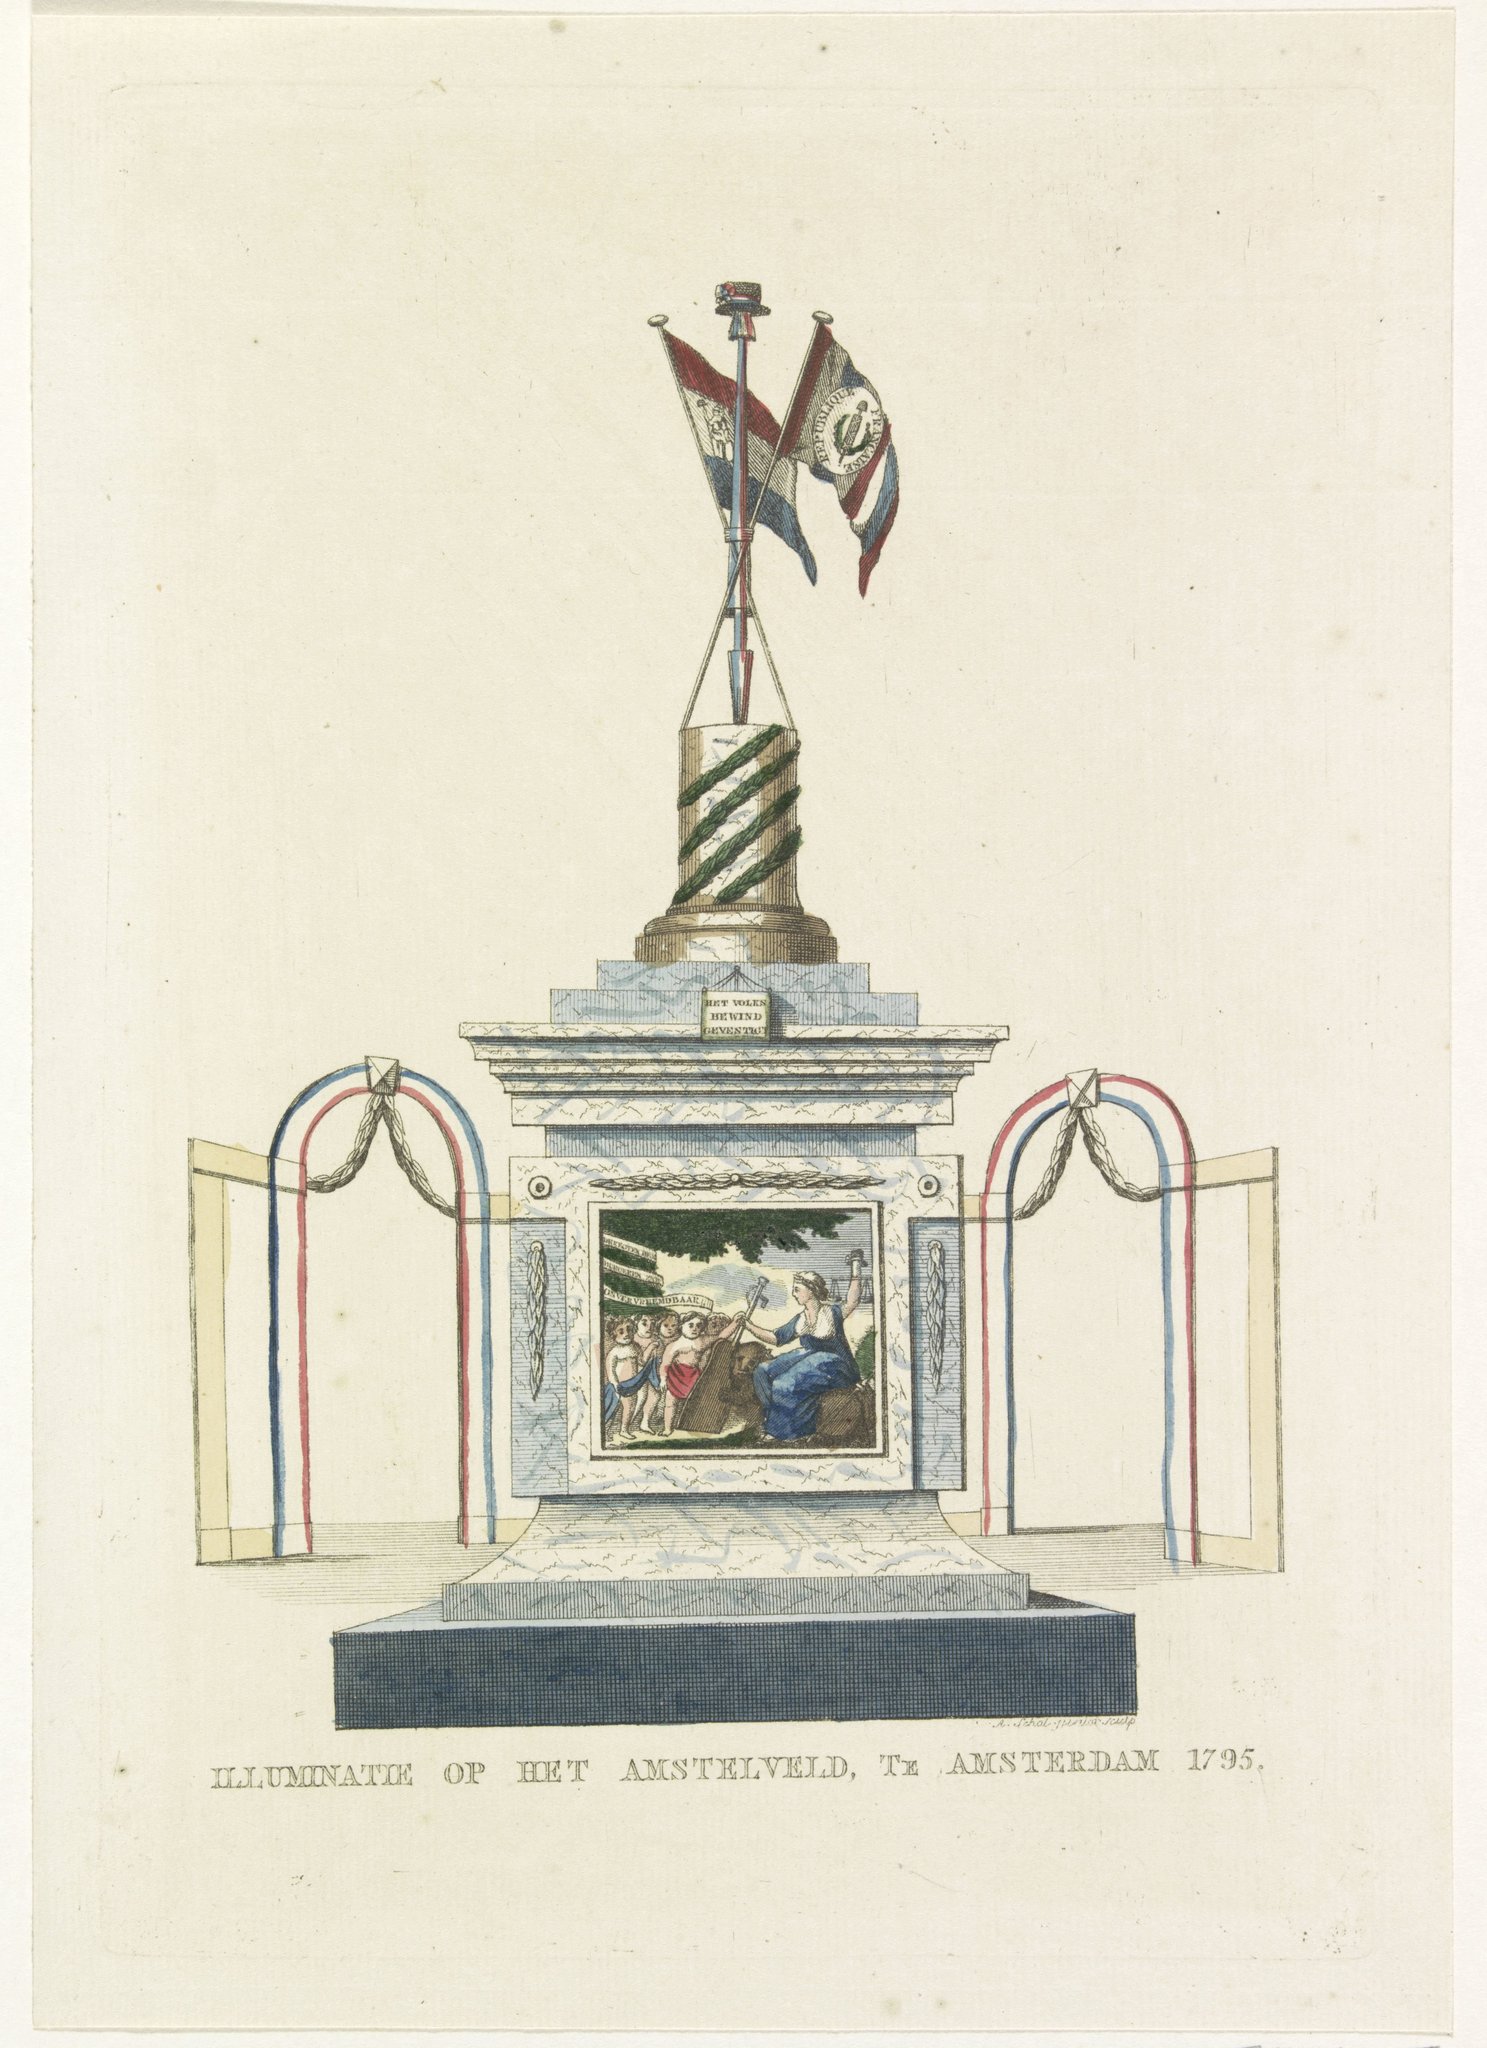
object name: print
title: Dertien decoraties bij het Alliantiefeest te Amsterdam in 1795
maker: a. schol (ii)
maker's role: print maker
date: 1795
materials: paper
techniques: etching, hand coloring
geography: netherlands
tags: personifications of countries, nations, states, districts, etc., festivities on events of national importance (+ festive decoration ~ festive activities), amsterdam, alliance with france (1795)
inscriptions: collector's mark: Lugt 2228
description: Het Volksbewind Gevestigd, allegorische decoratie opgericht op het Amstelveld te Amsterdam bij het Alliantiefeest op 19 juni 1795. Zuil bekroond met vrijheidshoed en de vlaggen van Nederland en Frankrijk. Chassinet waarin de Nederlandse Maagd zeven kinderen verwelkomt die de zeven provincies voorstellen. Onderdeel van een serie van dertien platen.